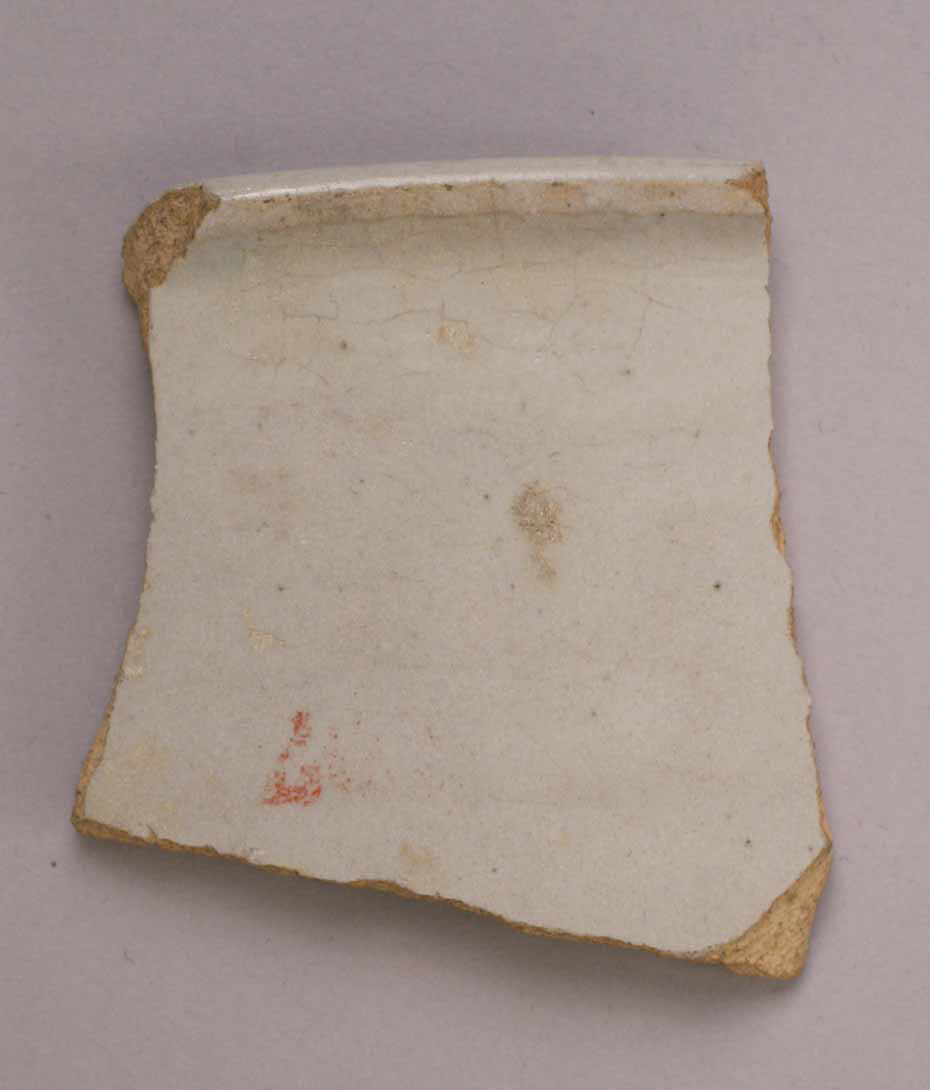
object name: fragment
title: Fragments of Ceramics with Opacified Glaze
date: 801-900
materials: earthenware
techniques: glazing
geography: iraq